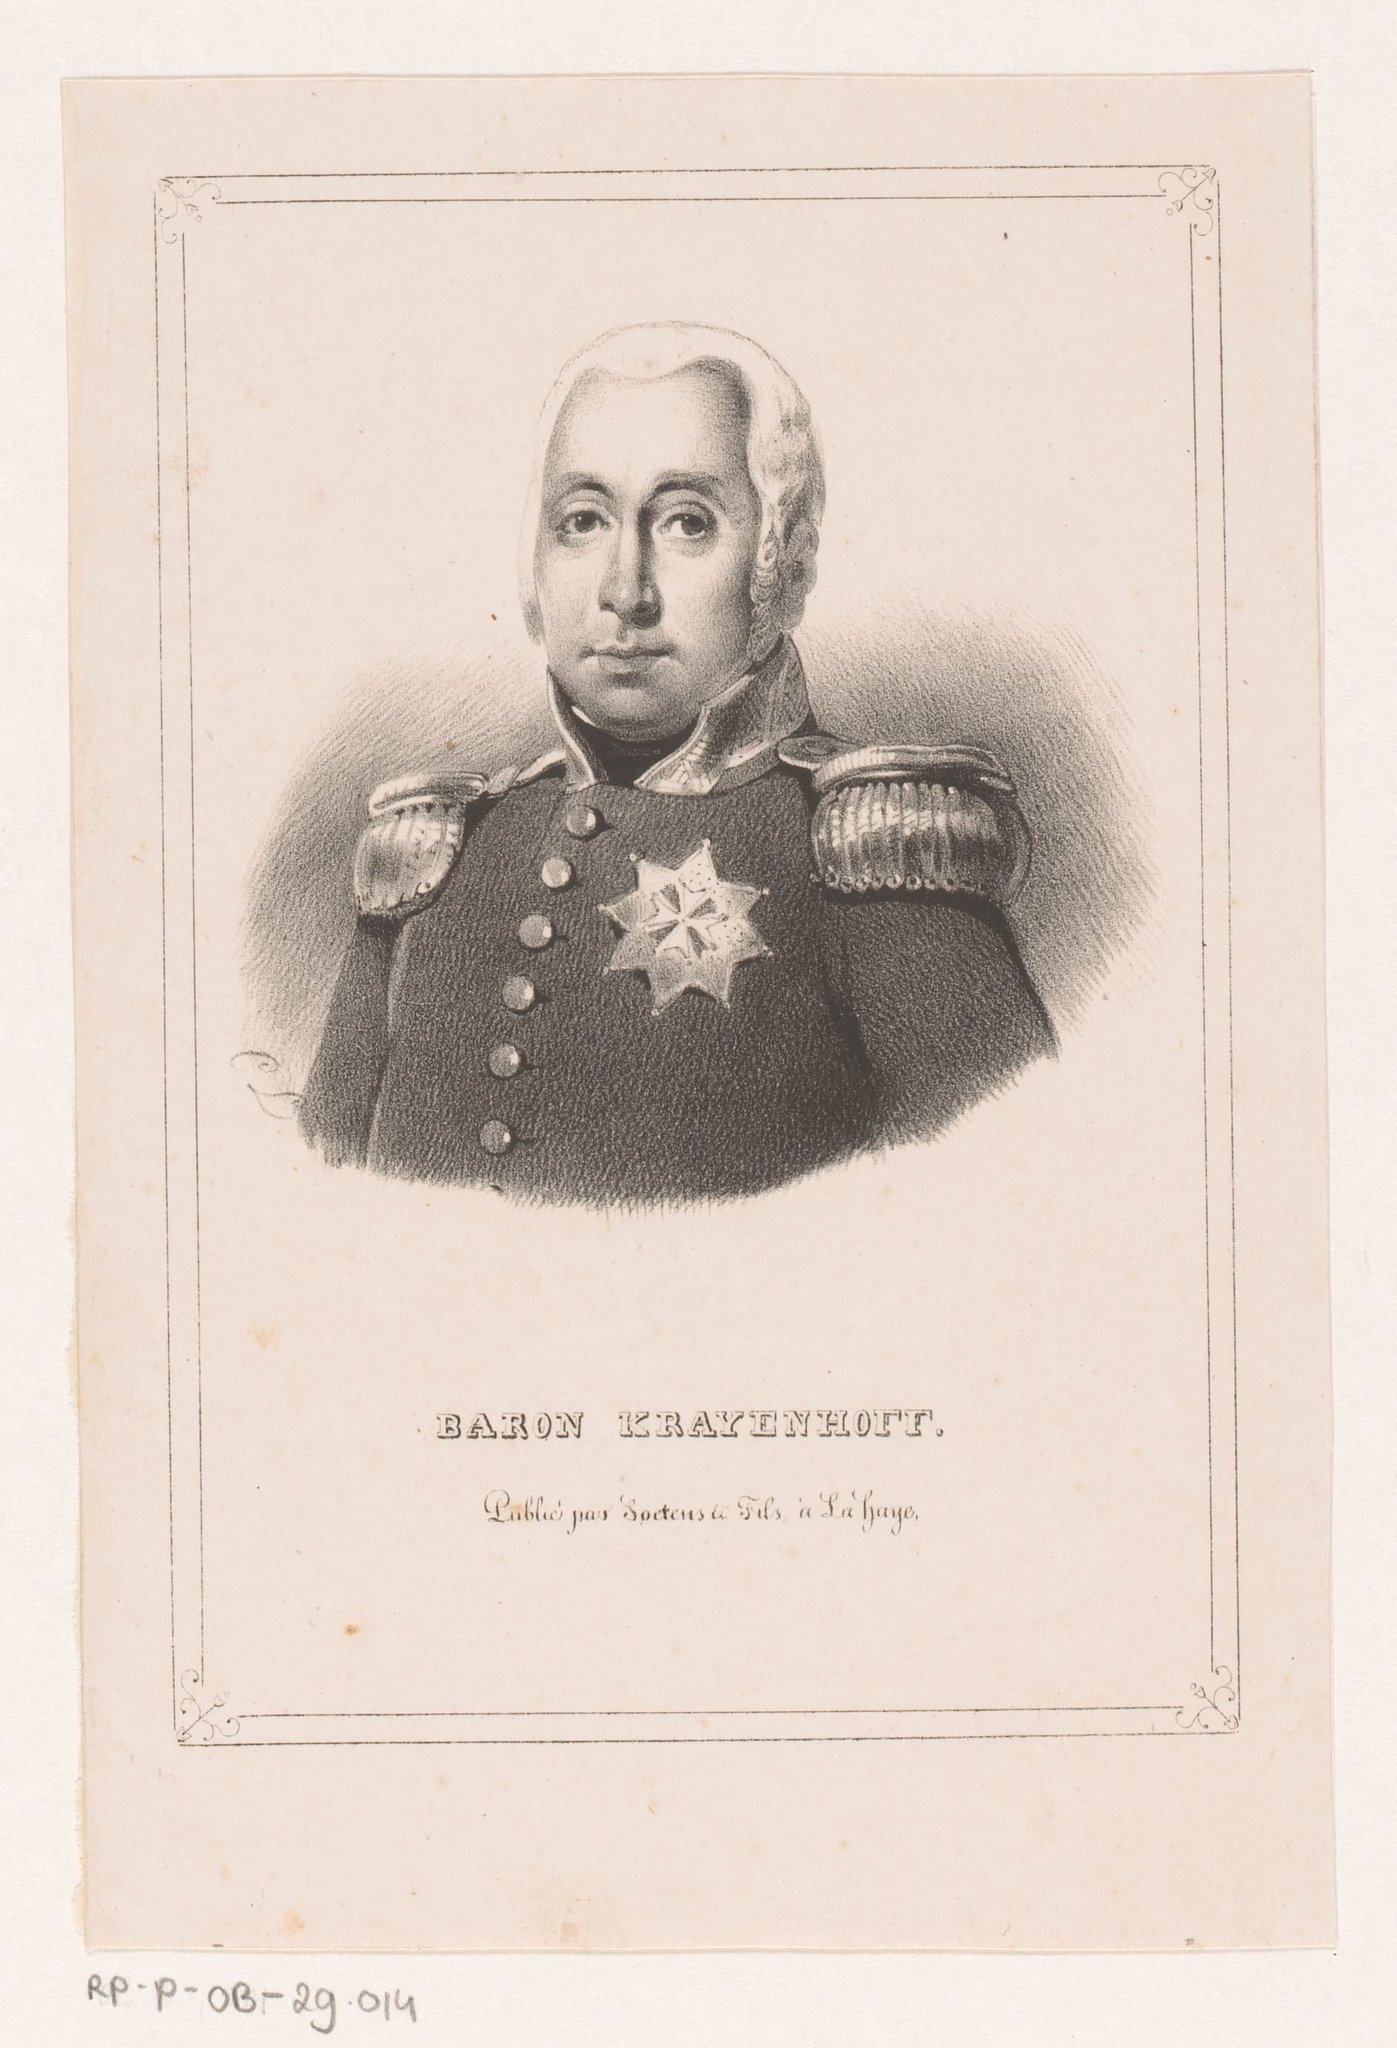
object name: print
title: Portret van Cornelius Rudolphus Theodorus Krayenhoff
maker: carel christiaan antony last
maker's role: print maker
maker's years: 1808-1876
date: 1837-1840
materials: paper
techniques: lithograph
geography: netherlands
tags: nijmegen, physicist, cornelis rudolphus theodorus krayenhoff, knighthood order, historical persons (+ (full) bust portrait)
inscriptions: collector's mark: Lugt 2228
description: De geportretteerde draagt een militair uniform met een ridderorde op zijn borst.